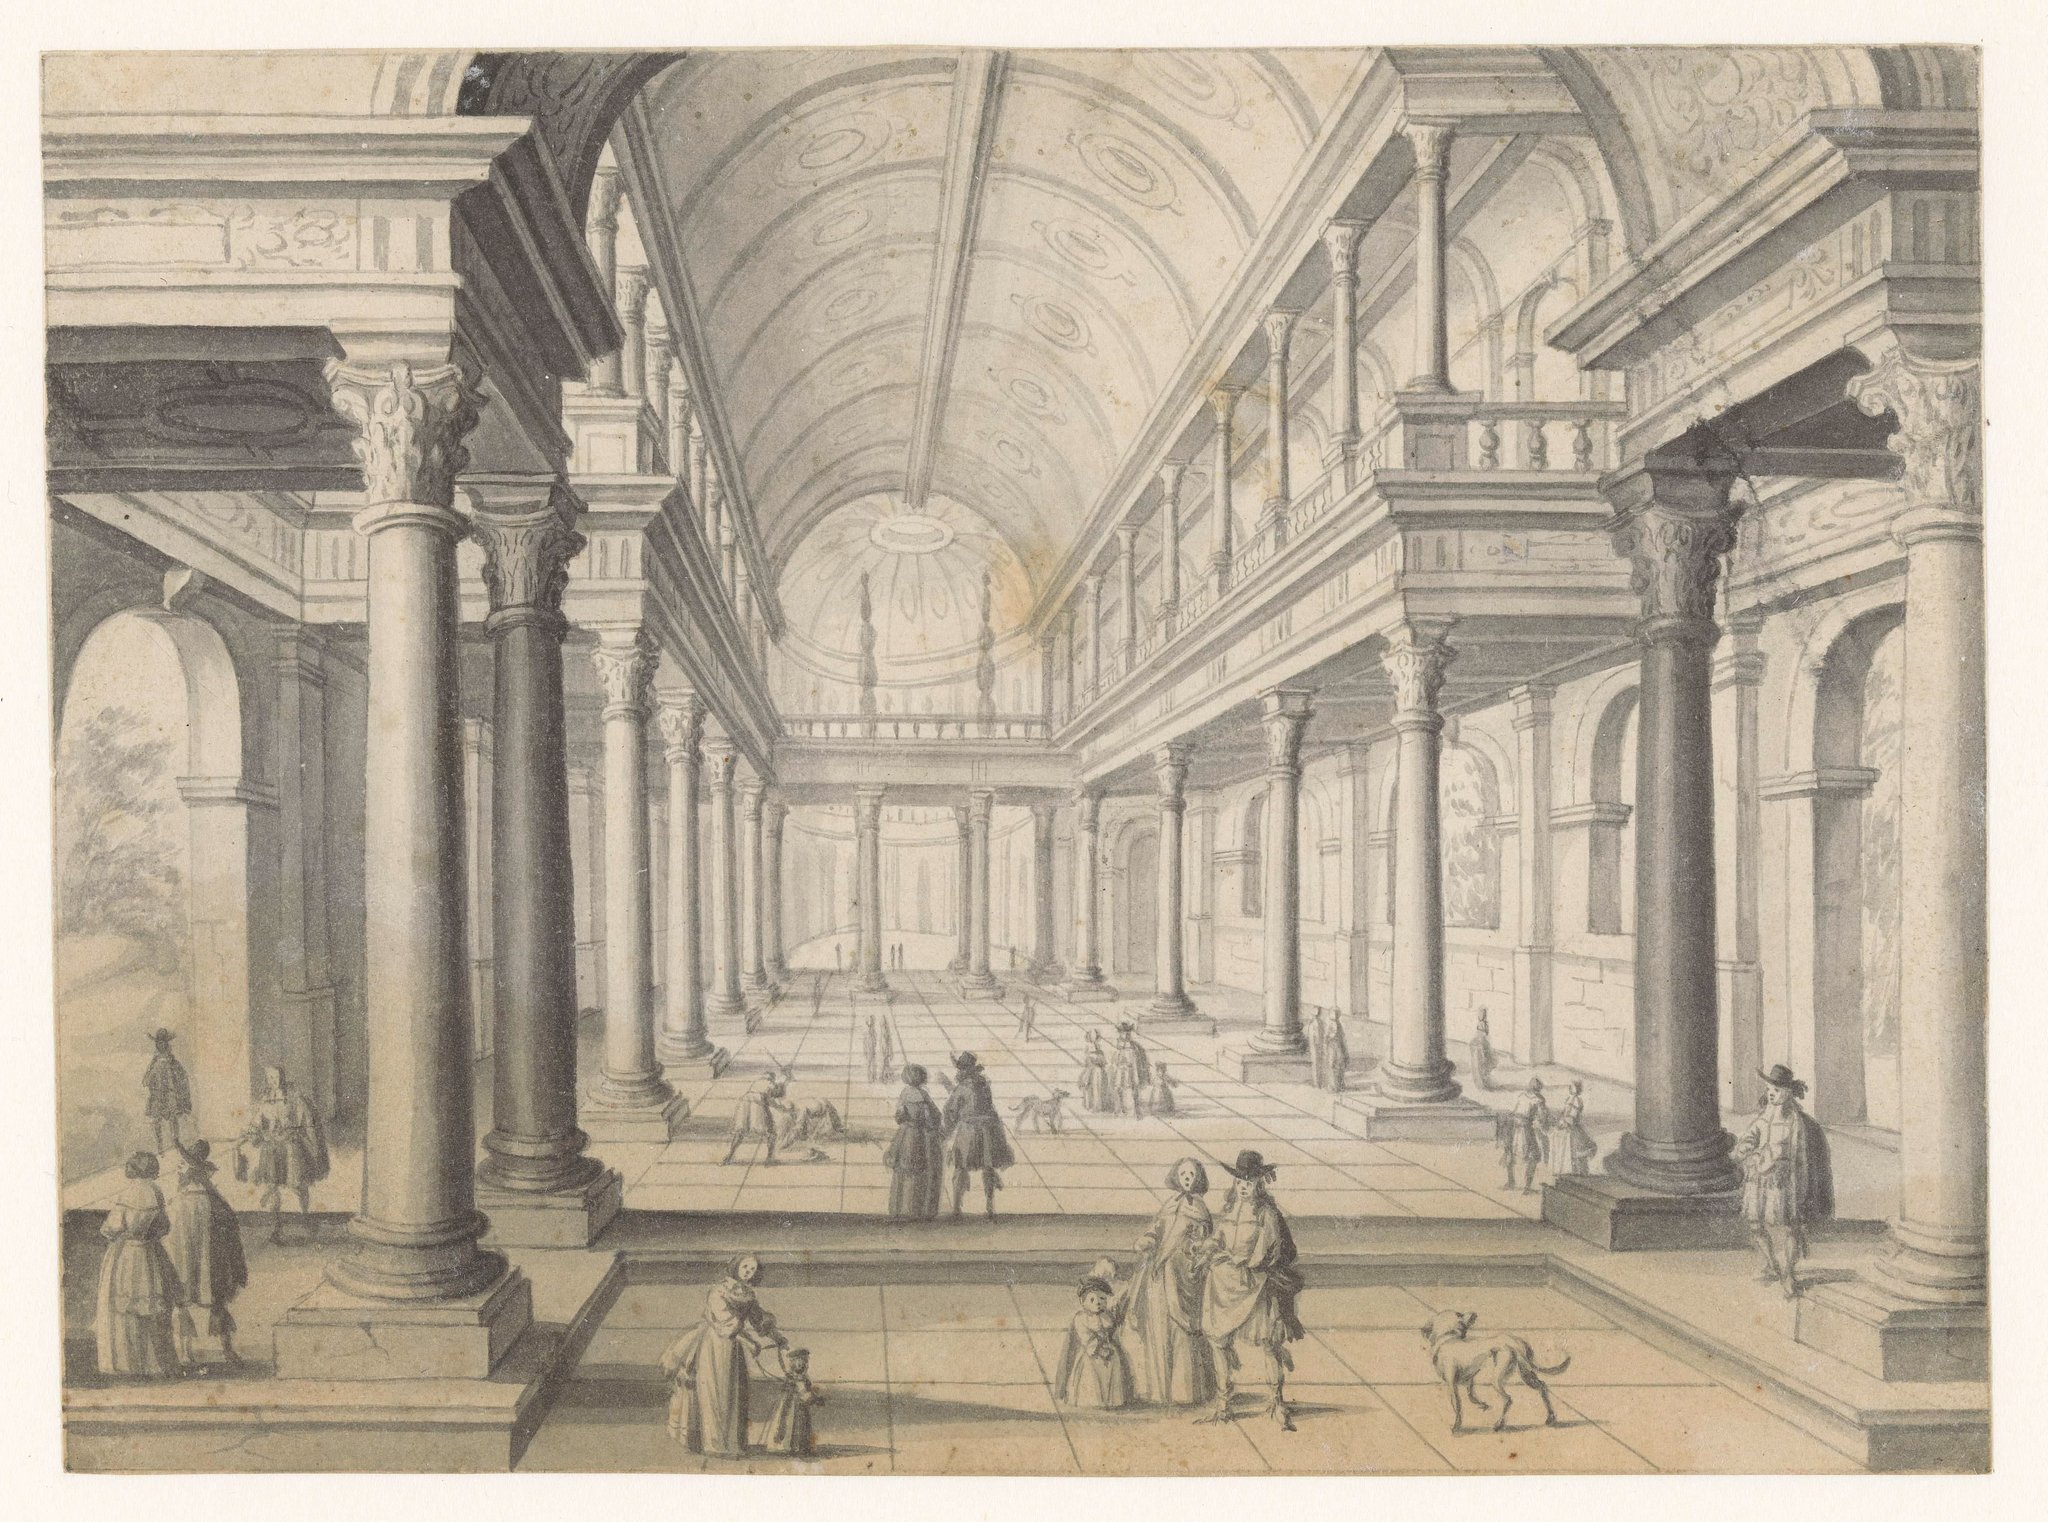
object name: drawing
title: Renaissance-zaal met figuren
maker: Anonymous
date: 1600-1699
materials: ink, paper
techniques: brush, pen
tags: gallery (spacious corridor)